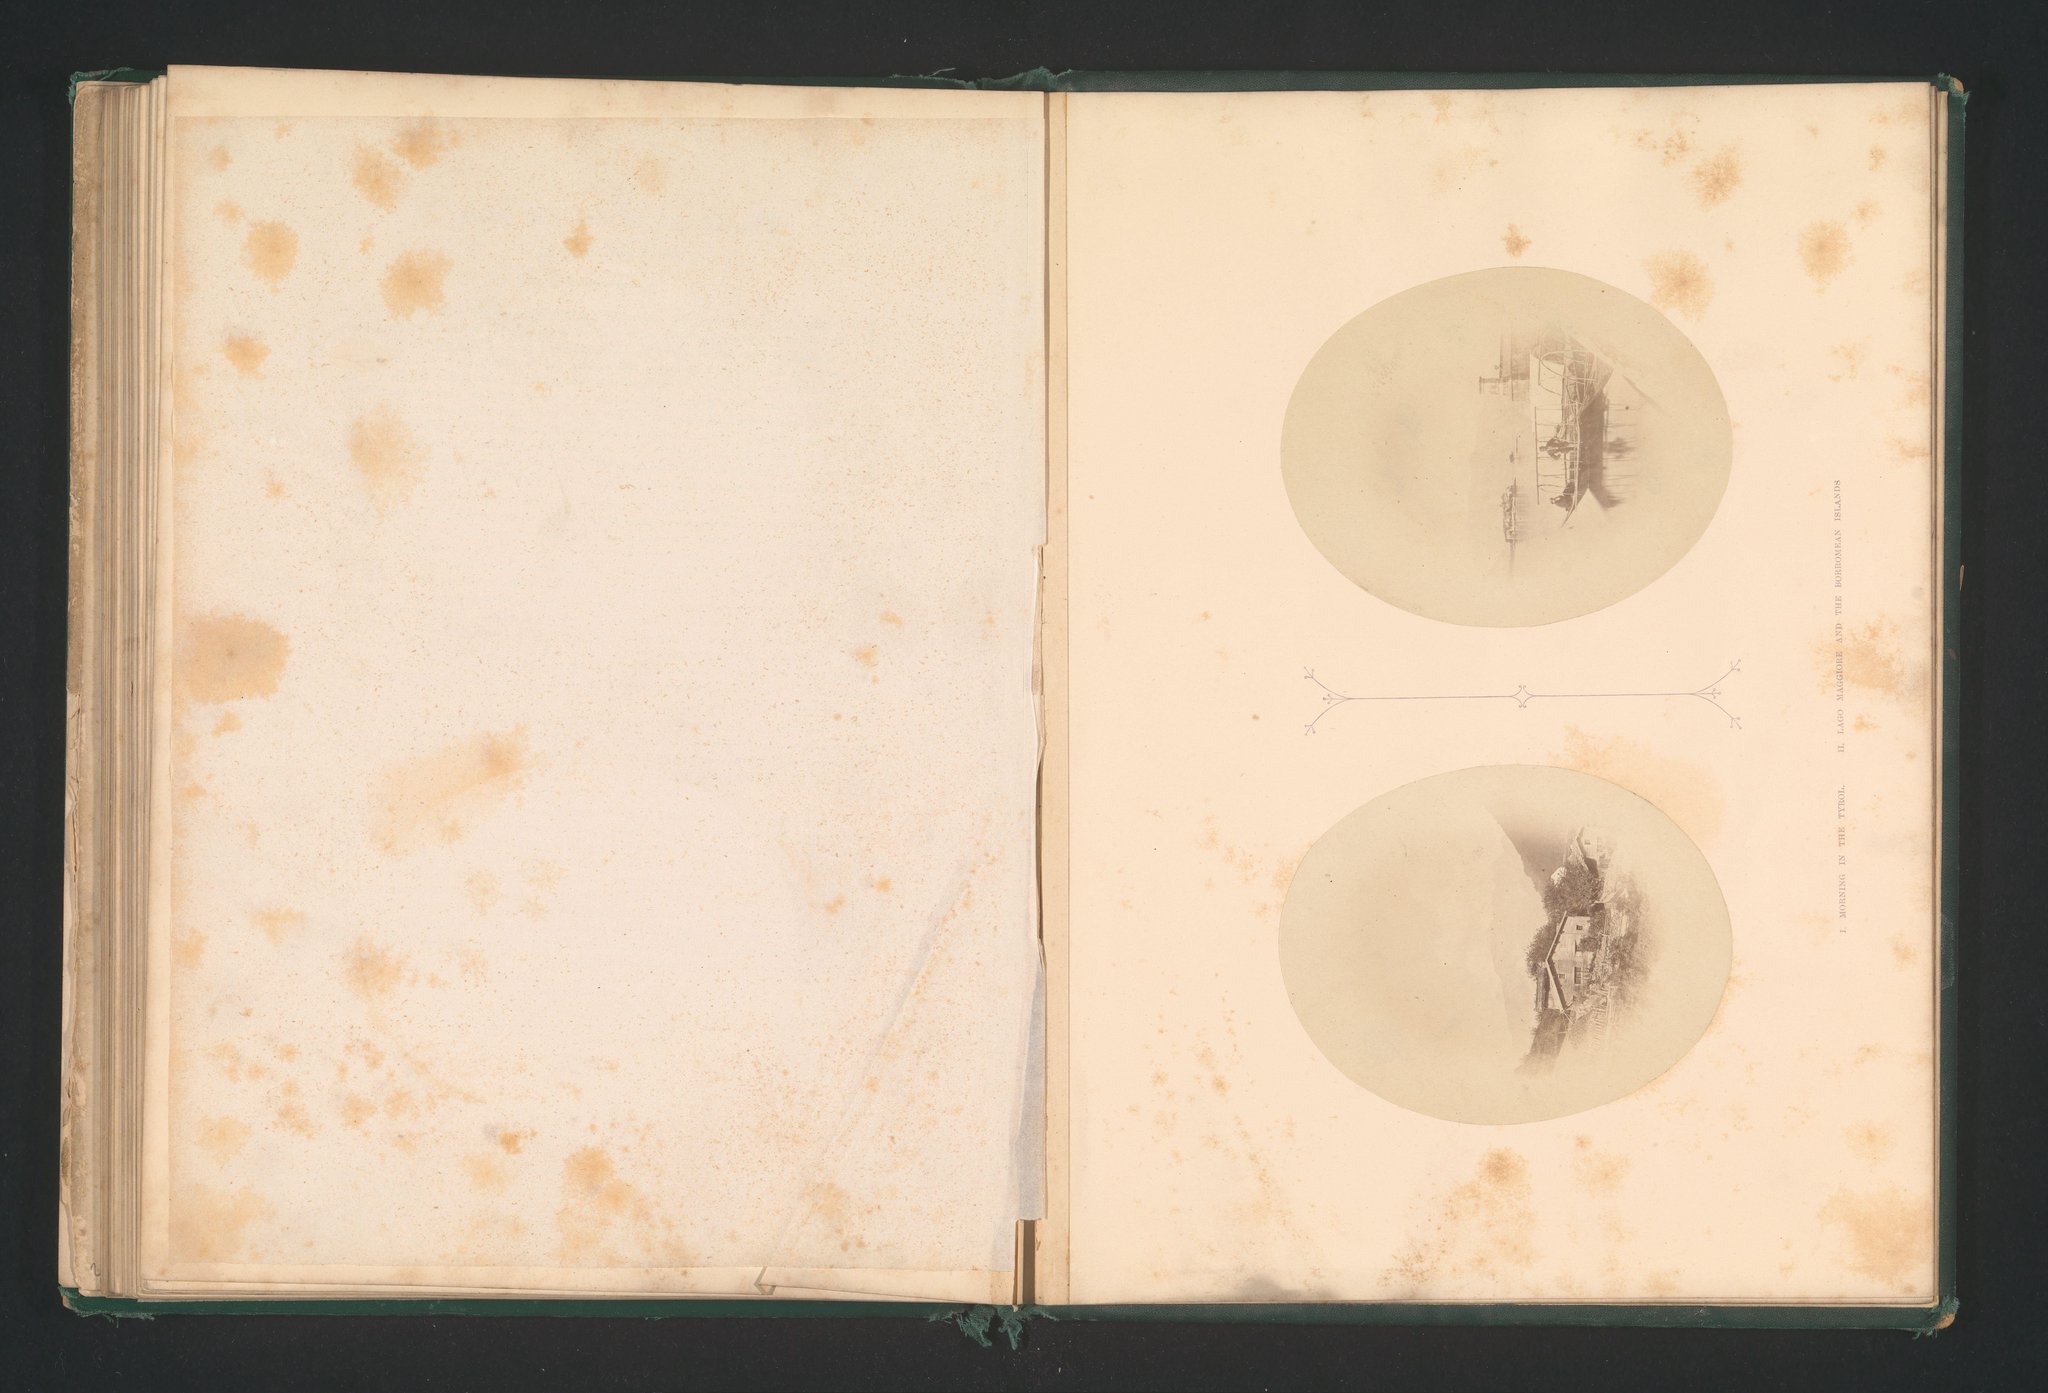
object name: page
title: Berglandschap met huizen in Tirol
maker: stephen thompson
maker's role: fotograaf, schrijver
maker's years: 1831-1893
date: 1863-1868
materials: photographic support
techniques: albumen print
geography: tirol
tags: landscapes in the temperate zone, rural housing, e.g. country-house, villa, cottage